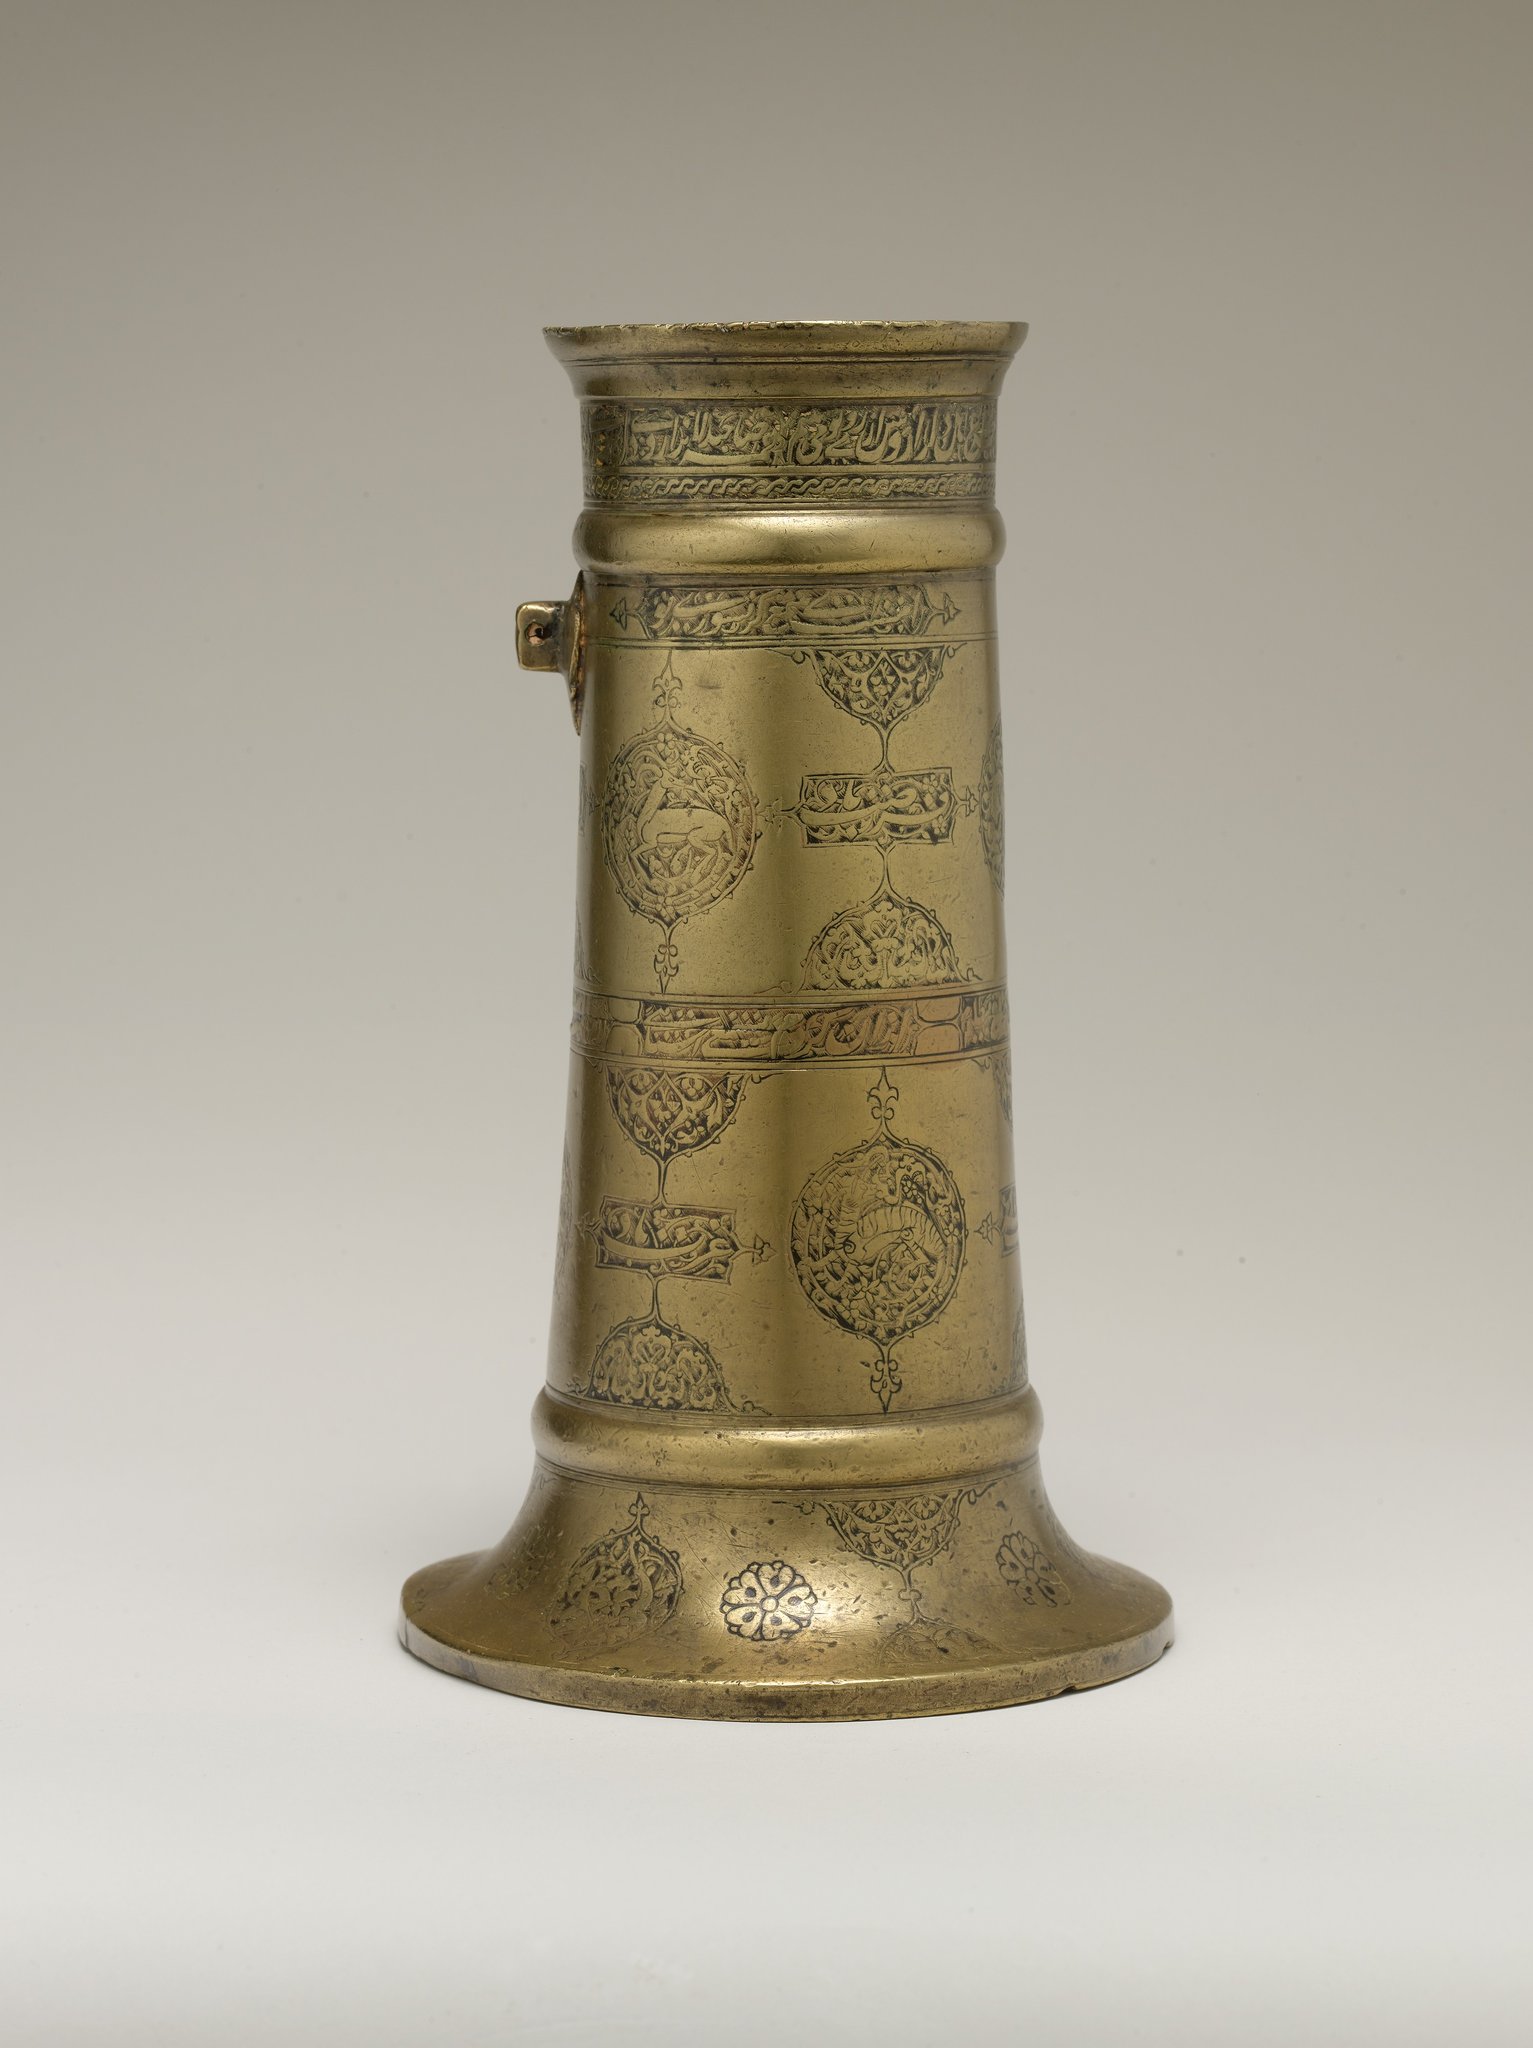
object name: candlestick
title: Engraved Lamp Stand with Cartouches and Medallions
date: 1501-1600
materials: brass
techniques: casting, engraving, inlay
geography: iran